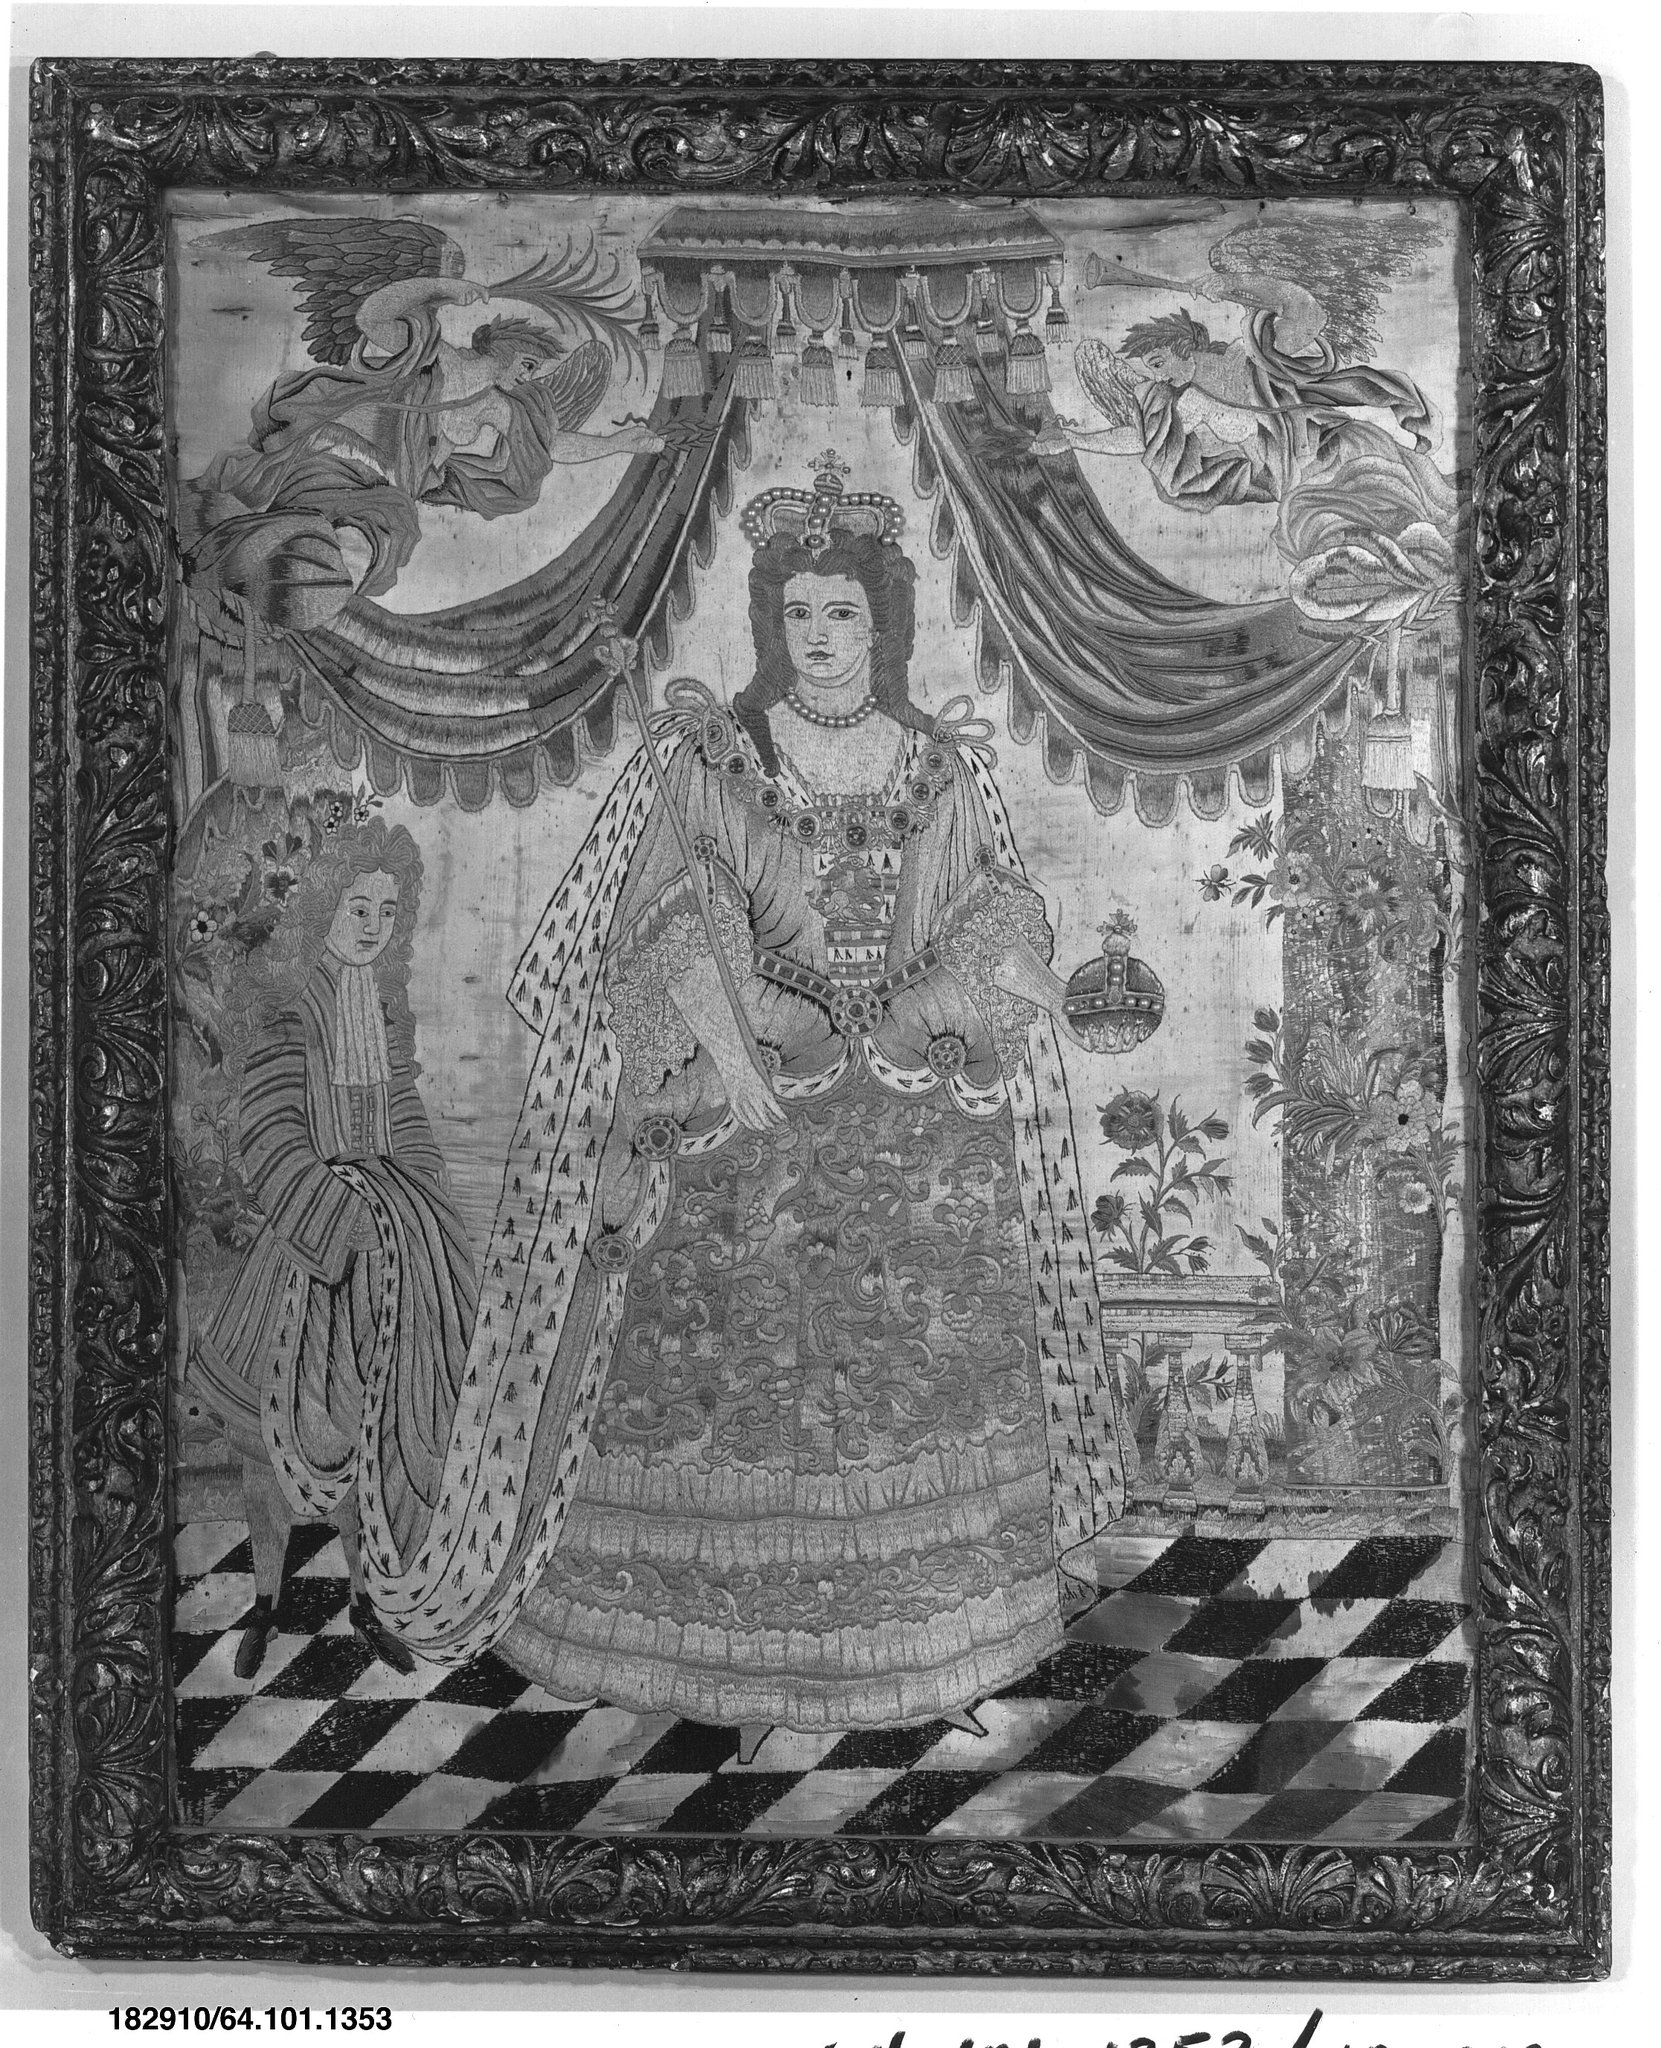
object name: embroidered picture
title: Embroidered portrait of Queen Anne of Great Britain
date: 1701-1725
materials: textile, silk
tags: queens,men,portraits,women